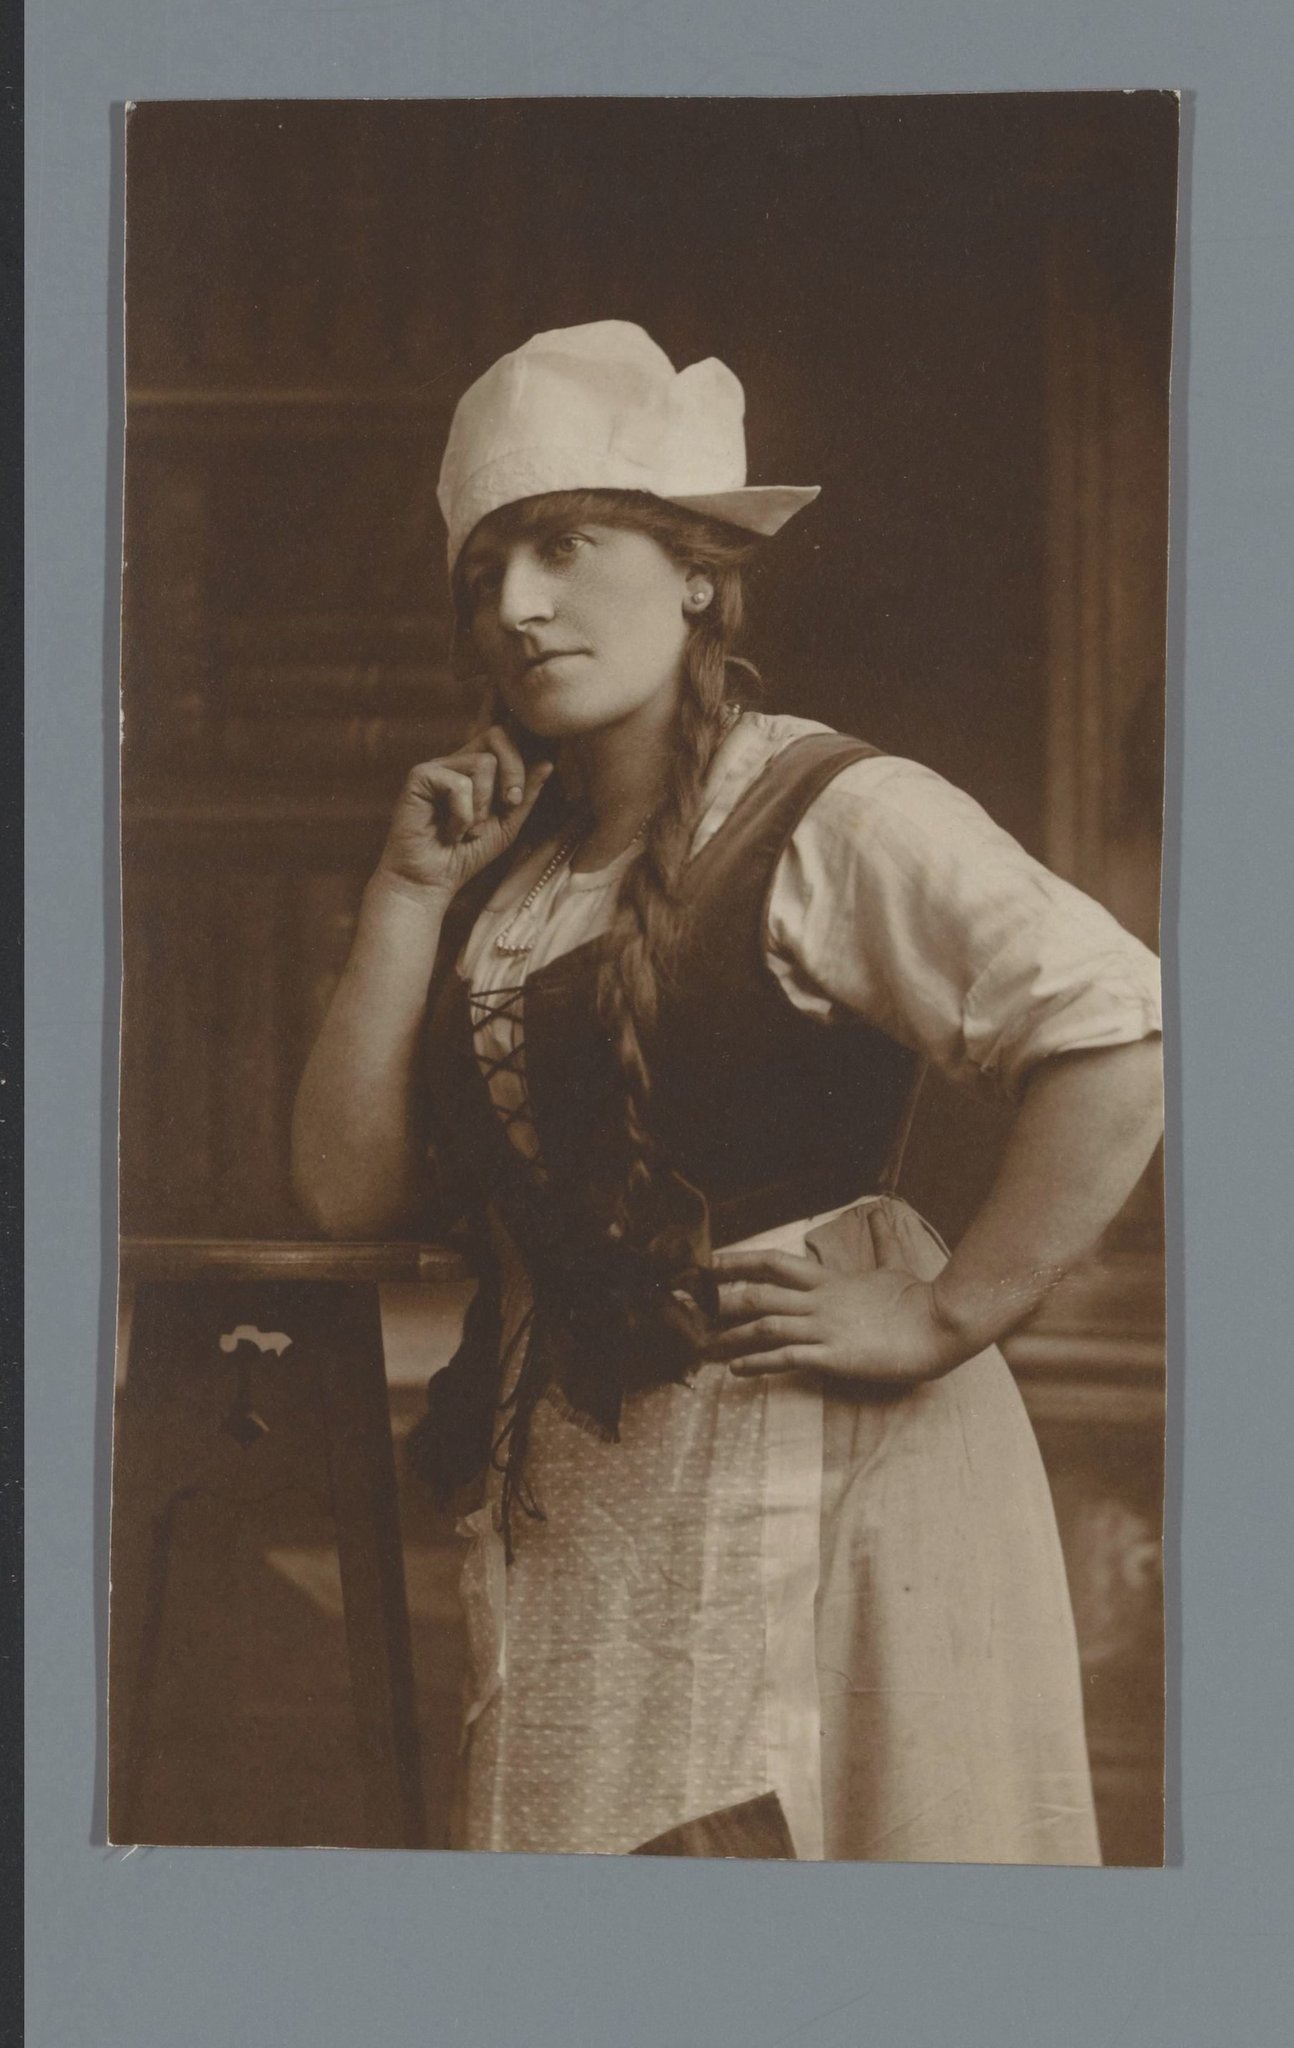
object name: ansichtkaart, prentbriefkaart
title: Portret van een onbekende vrouw in klederdracht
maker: Anonymous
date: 1915-1930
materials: photographic support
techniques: gelatin silver print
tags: adult woman, folk costume, regional costume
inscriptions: number: ‘7086’